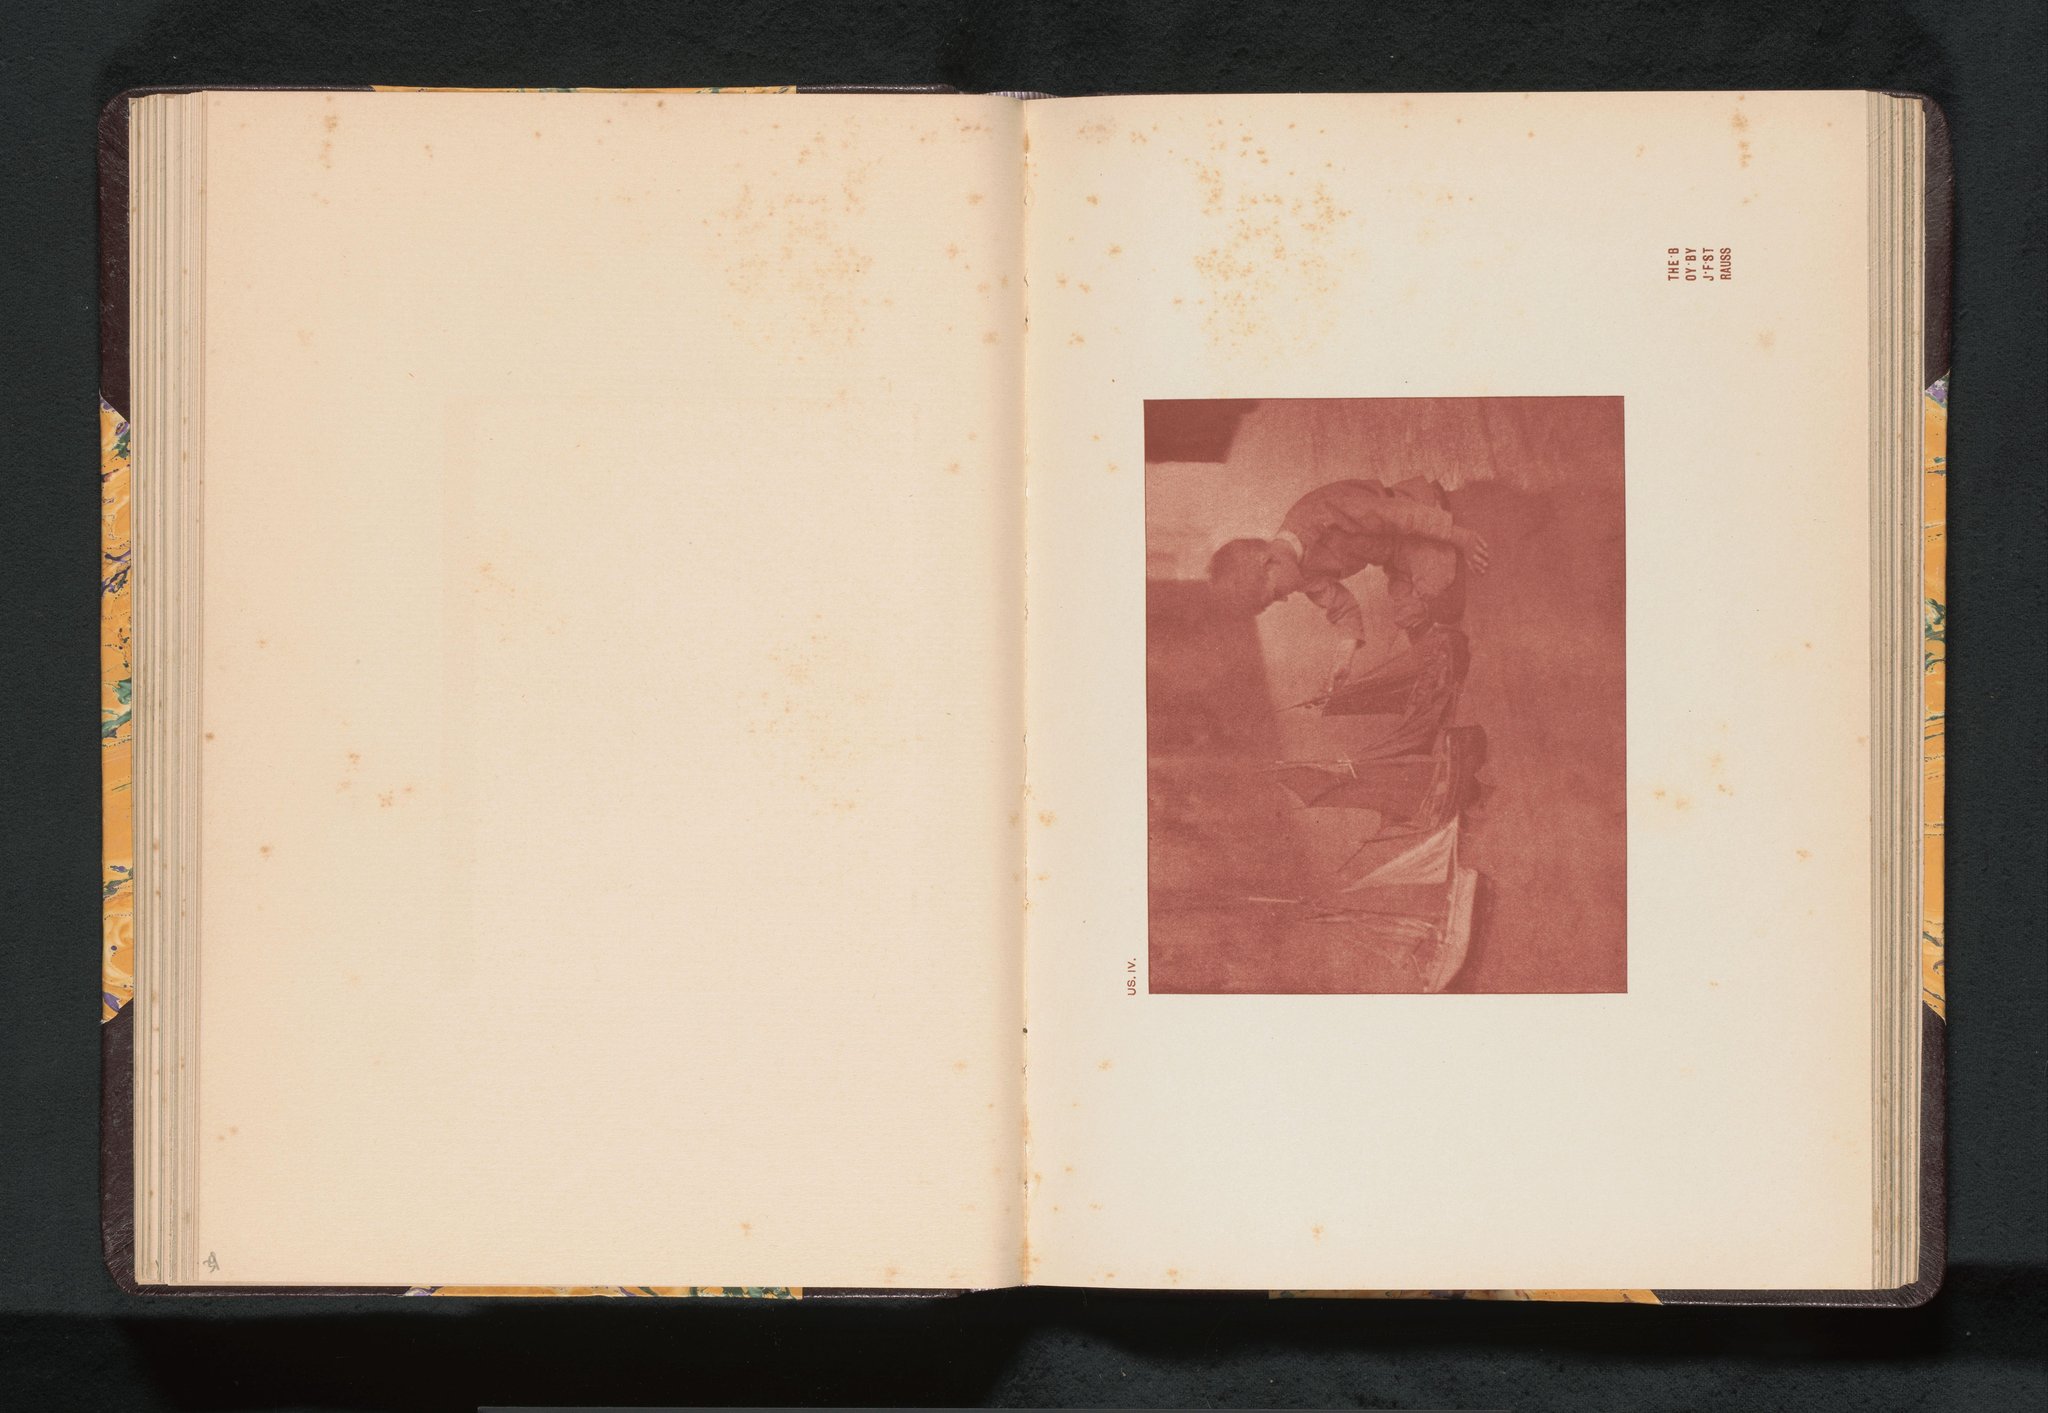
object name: photomechanical print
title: Jongen spelend met scheepsmodellen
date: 1900-1905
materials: paper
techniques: autotype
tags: boy (child between toddler and youth), ship-model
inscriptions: inscription: ‘US. IV.’, inscription: ‘The boy by J.F. Strauss’